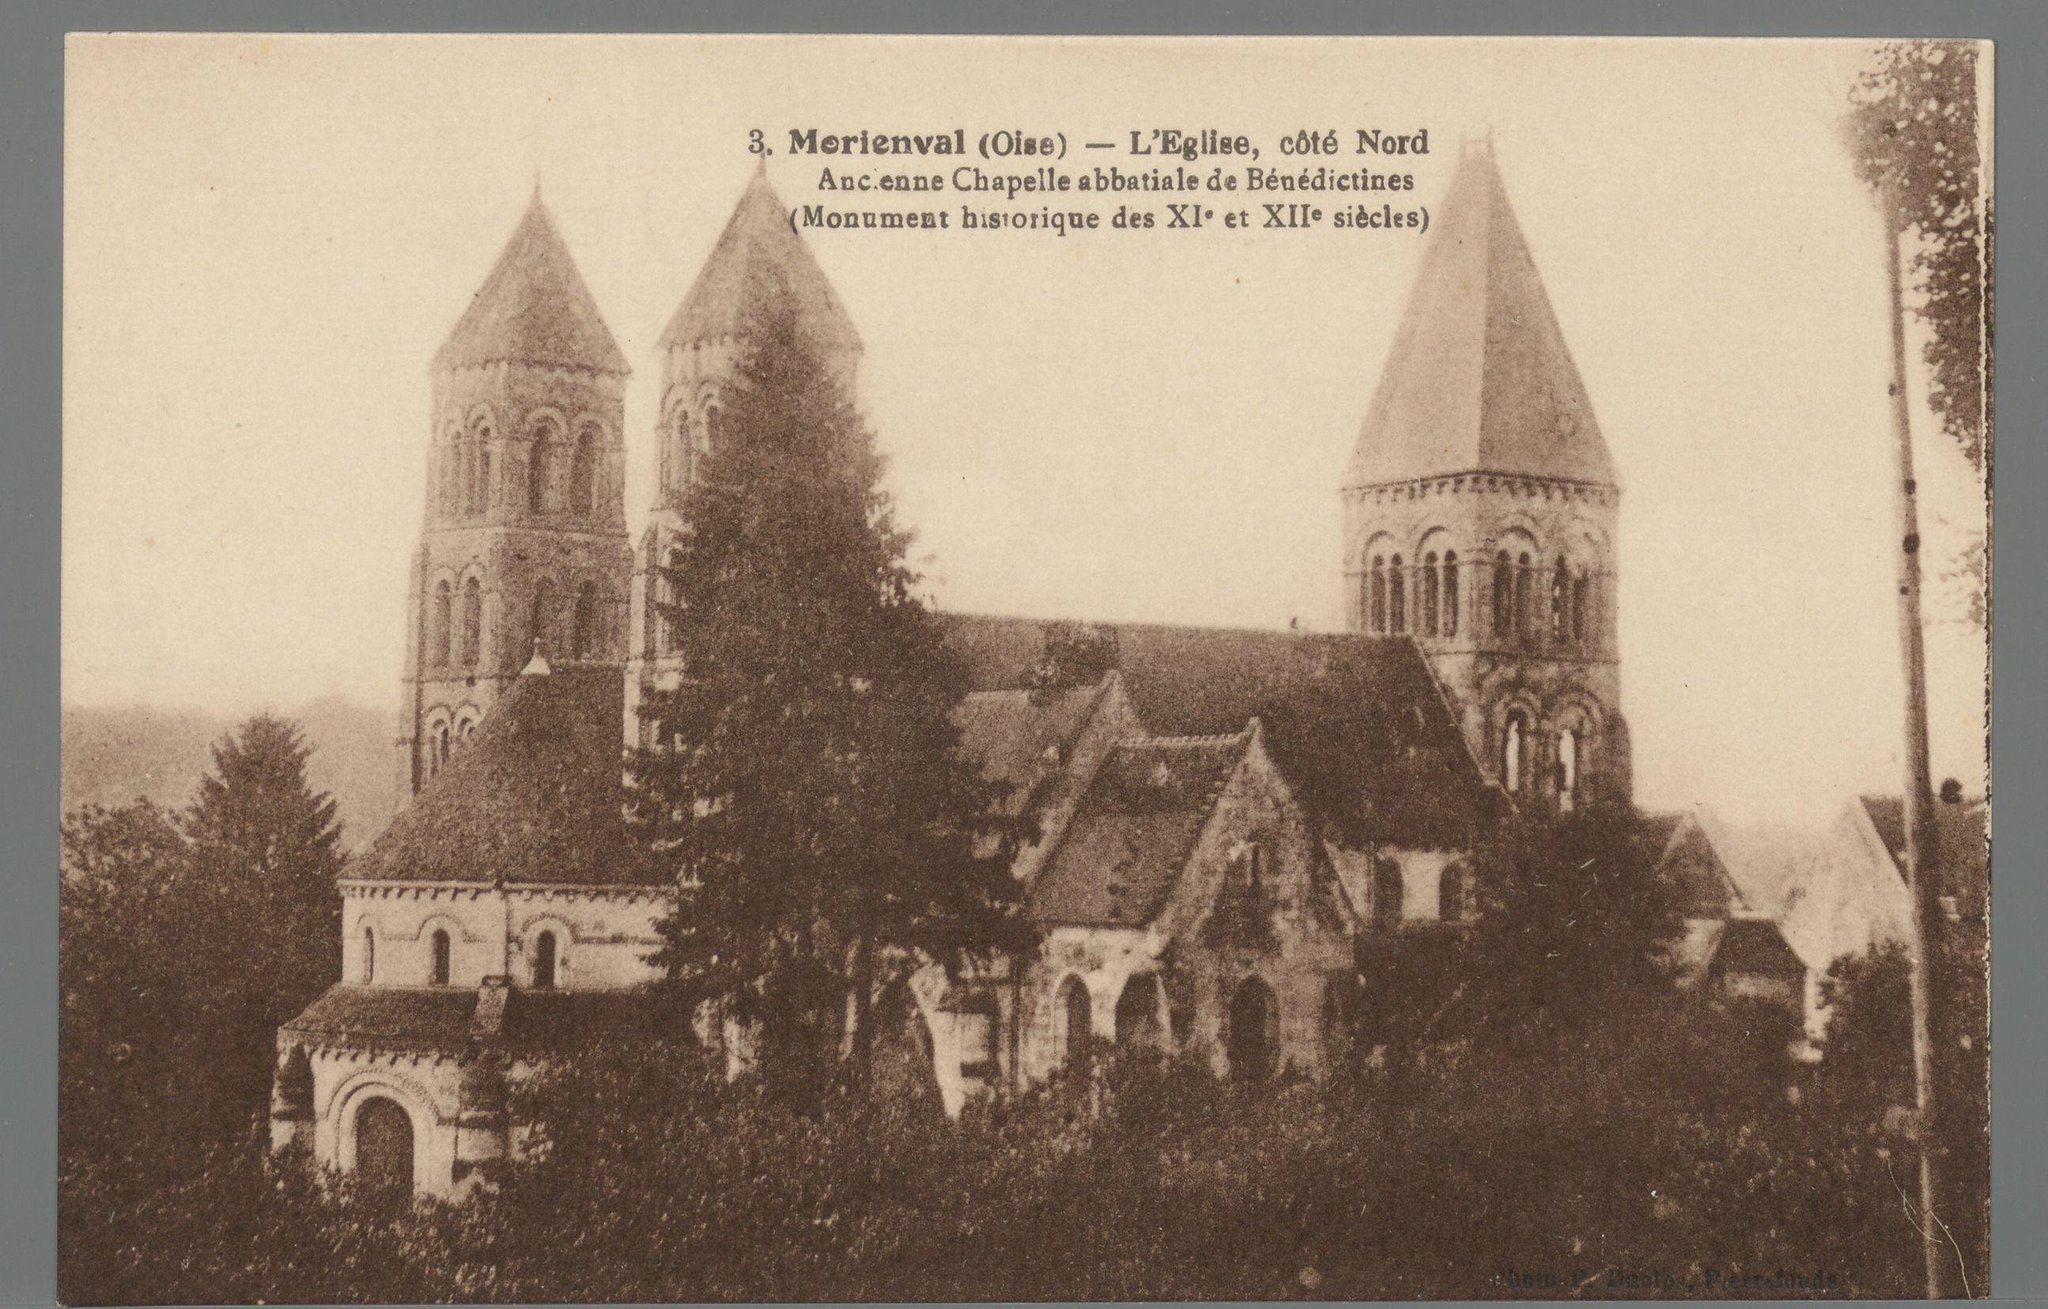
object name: ansichtkaart, prentbriefkaart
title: Morienval (Oise) - L'Eglise, côté Nord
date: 1903-1930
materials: cardboard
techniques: photograph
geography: morienval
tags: church (exterior)